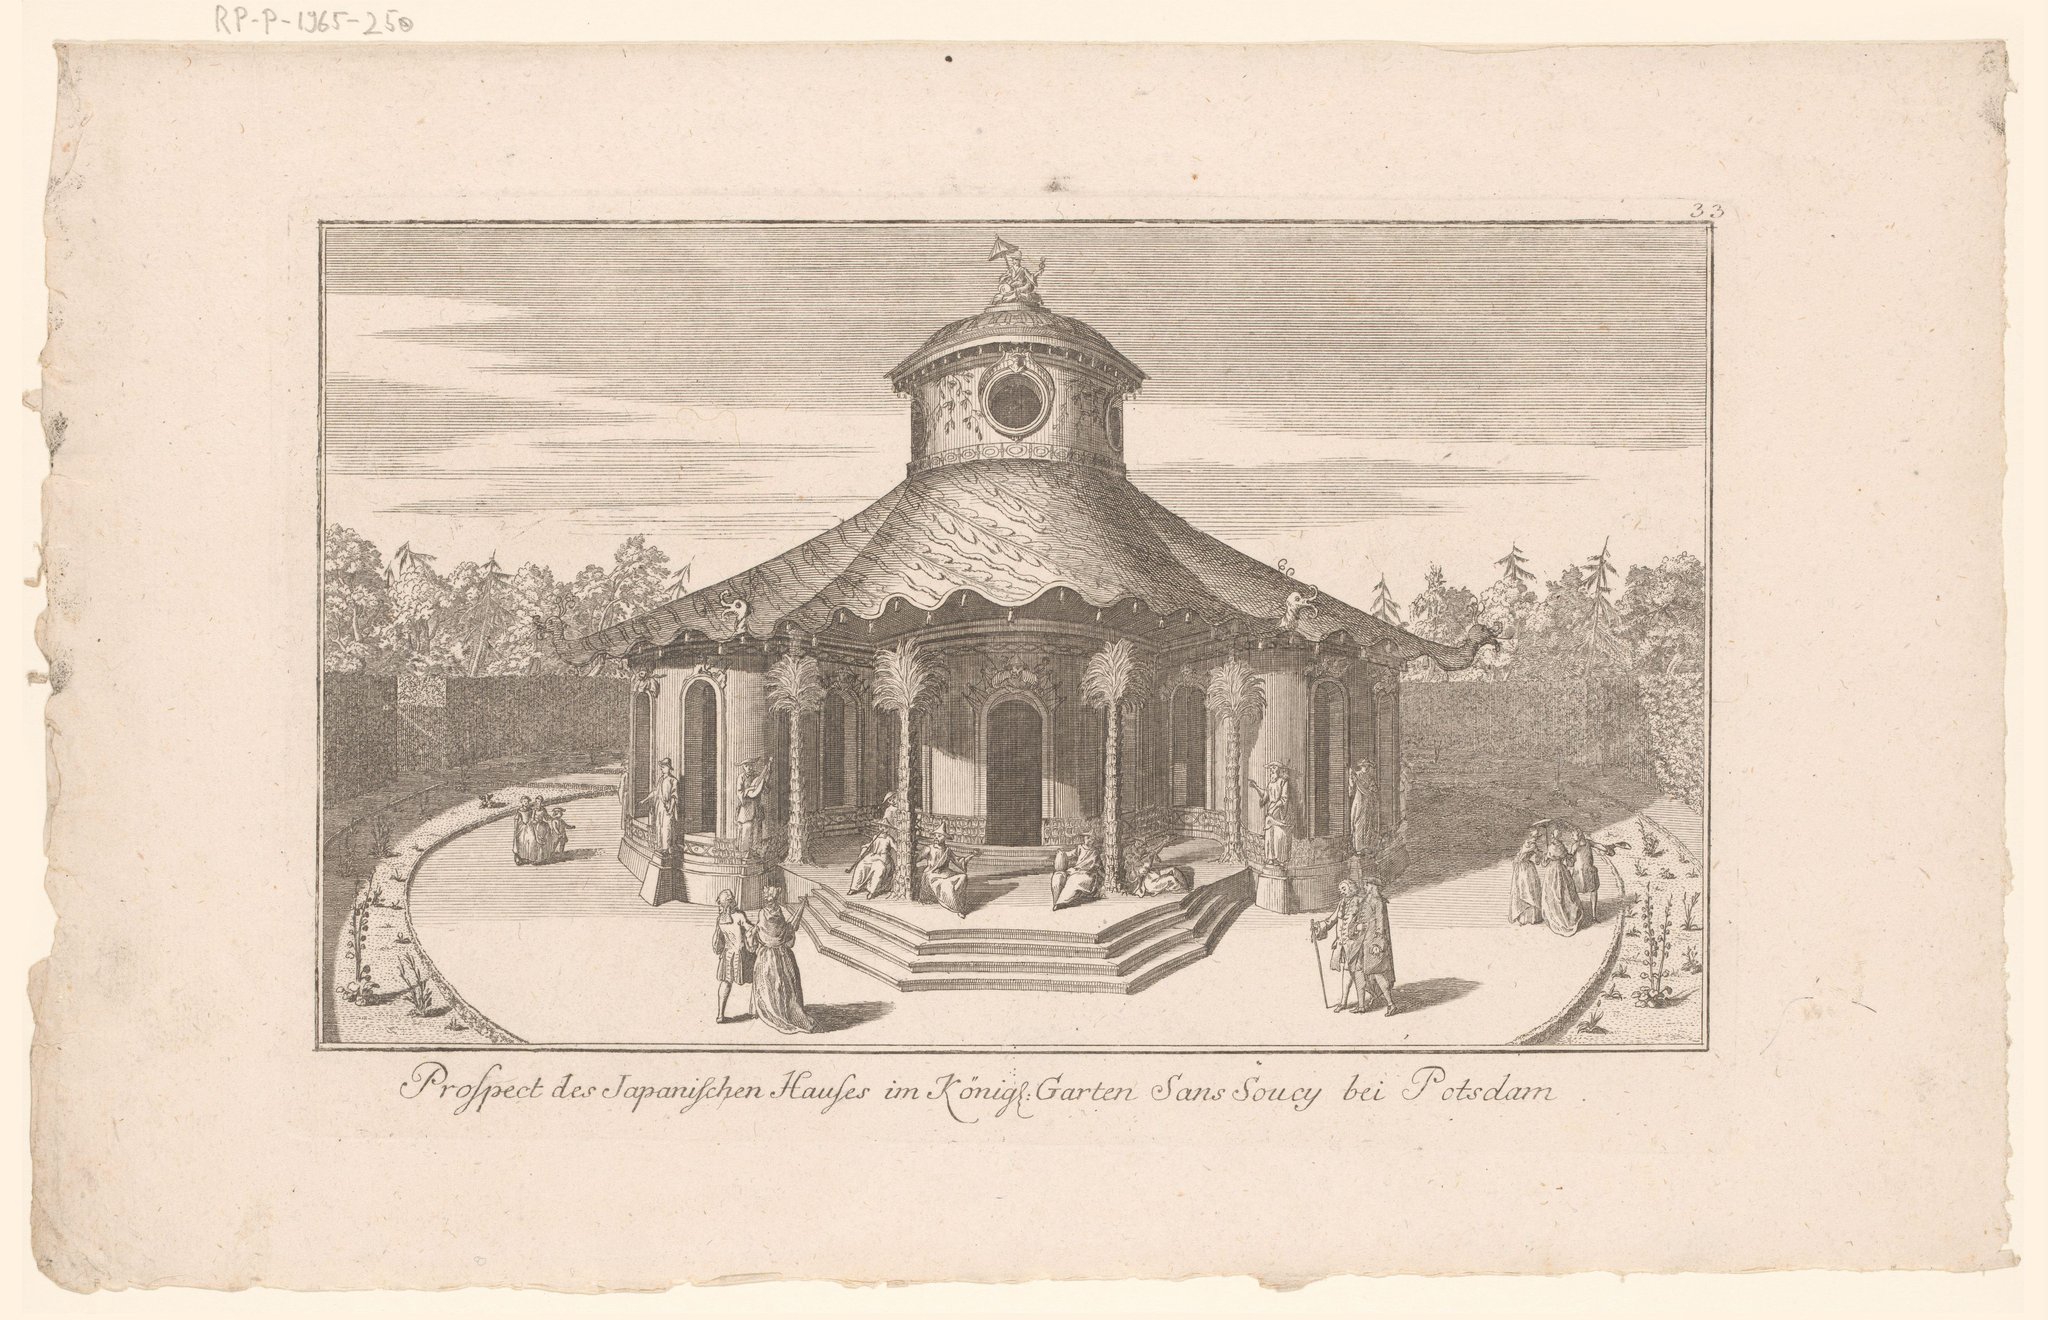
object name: print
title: Prospect des Japanischen Hauses im Königl. Garten Sans-Soucy bei Potsdam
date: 1747-1774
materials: paper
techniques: etching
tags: castle, french or architectonic garden; formal garden, summer-house, arbour, garden-house (dutch: 'theekoepel')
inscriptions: collector's mark: Lugt 2228, collector's mark: Lugt 2760